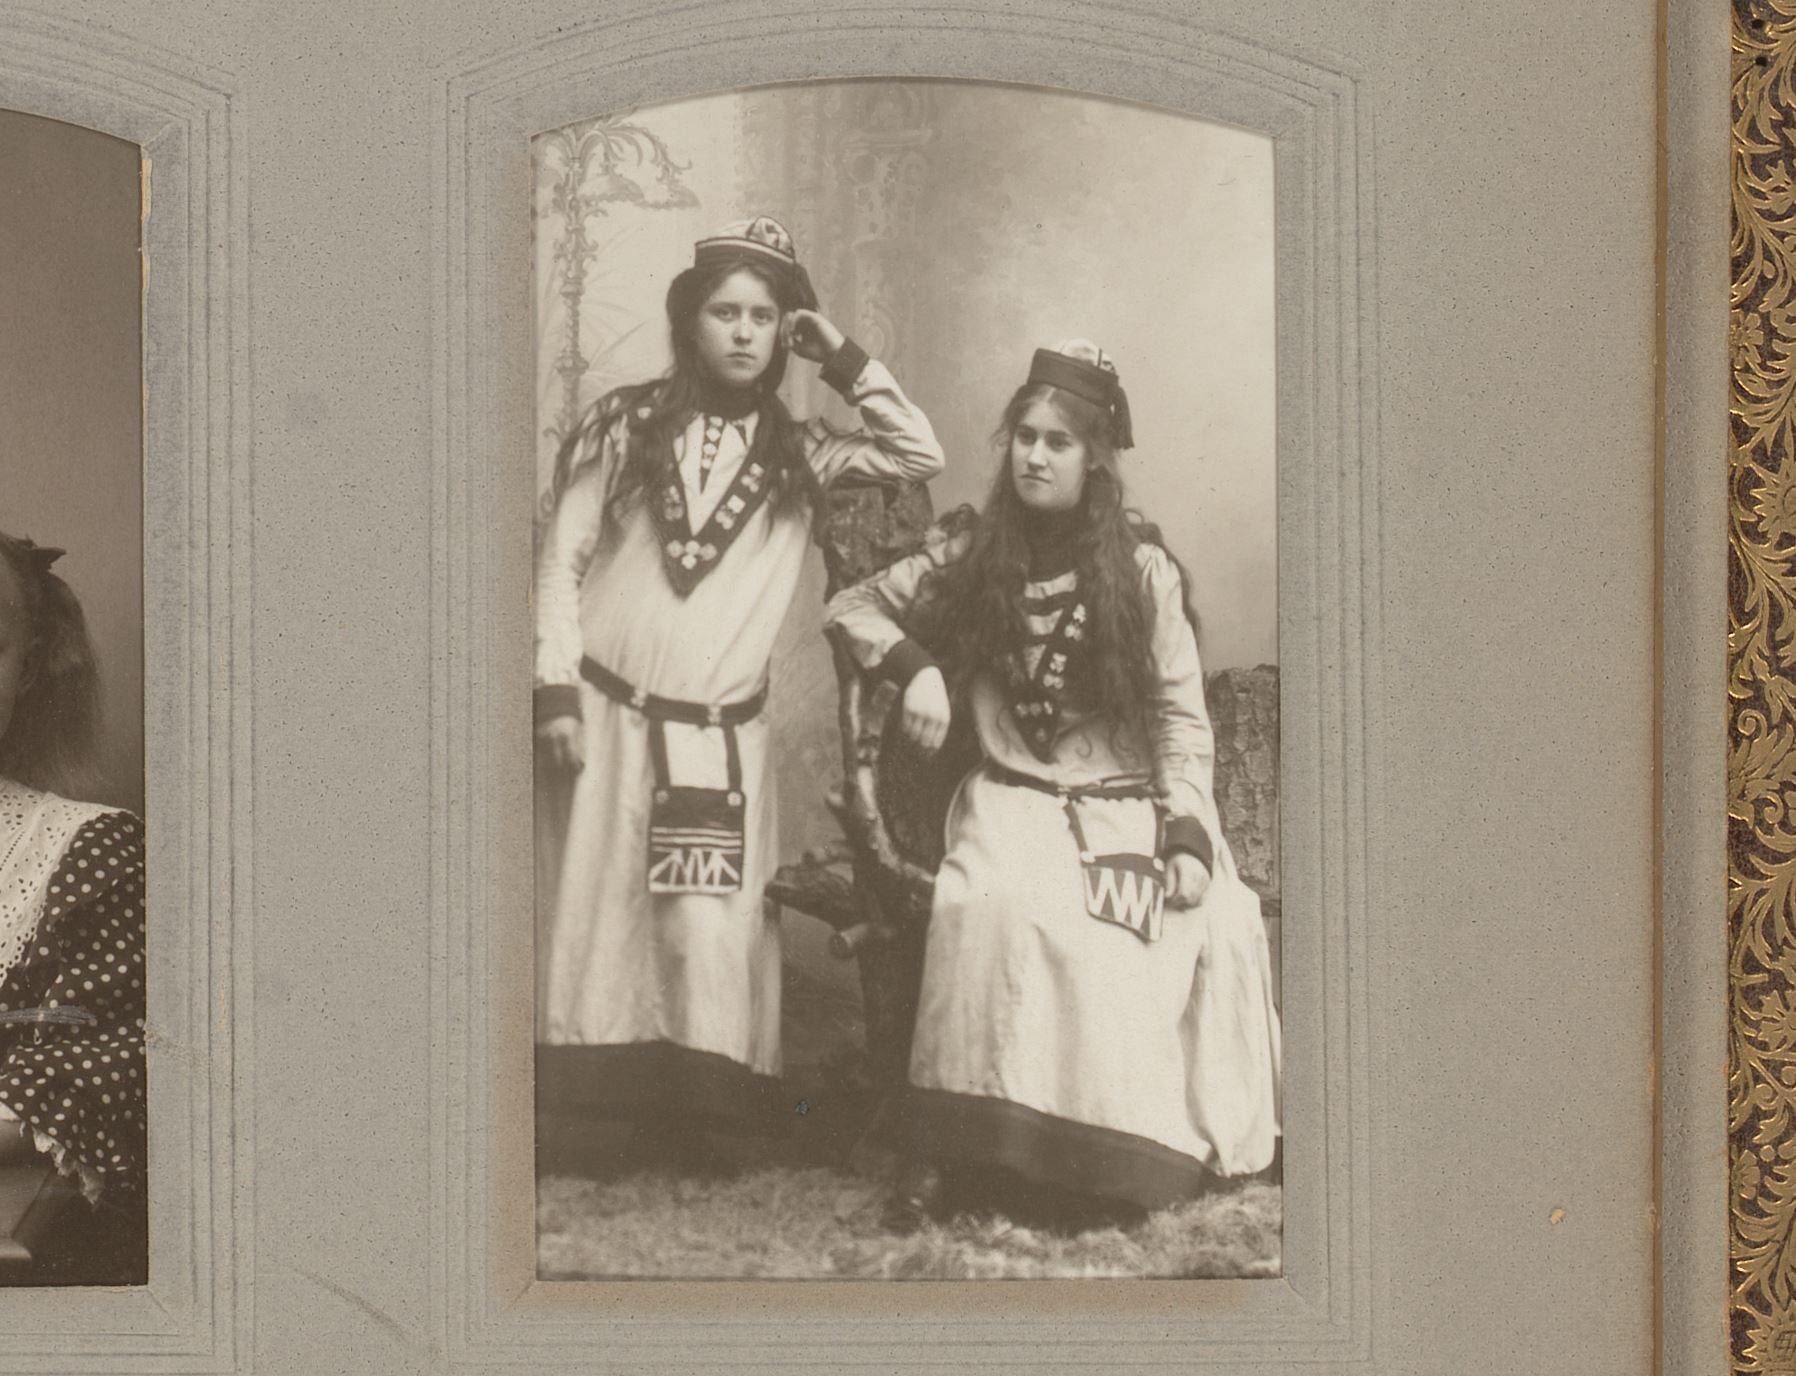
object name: album leaf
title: Portret van twee jonge vrouwen in kostuum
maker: hedvig rosendahl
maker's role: fotograaf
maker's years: 1867-1929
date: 1895-1920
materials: cardboard, photographic support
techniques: matte daylight collodion silver print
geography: stockholm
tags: historical persons - bb - woman, adolescent, young woman, maiden (+ two persons), clothes, costume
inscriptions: inscription: ‘Hedvig Rosendahls/ Atelier/ Stockholm/ Allm. Telef./ 42/ 10778/ Drotninggatan/ Allm. Telef./ & 51/ 11087/ Malmskilnadsgatan 48 c/ Allm. Tel. 6290./ Plåten förvaras för efterbeställning.’